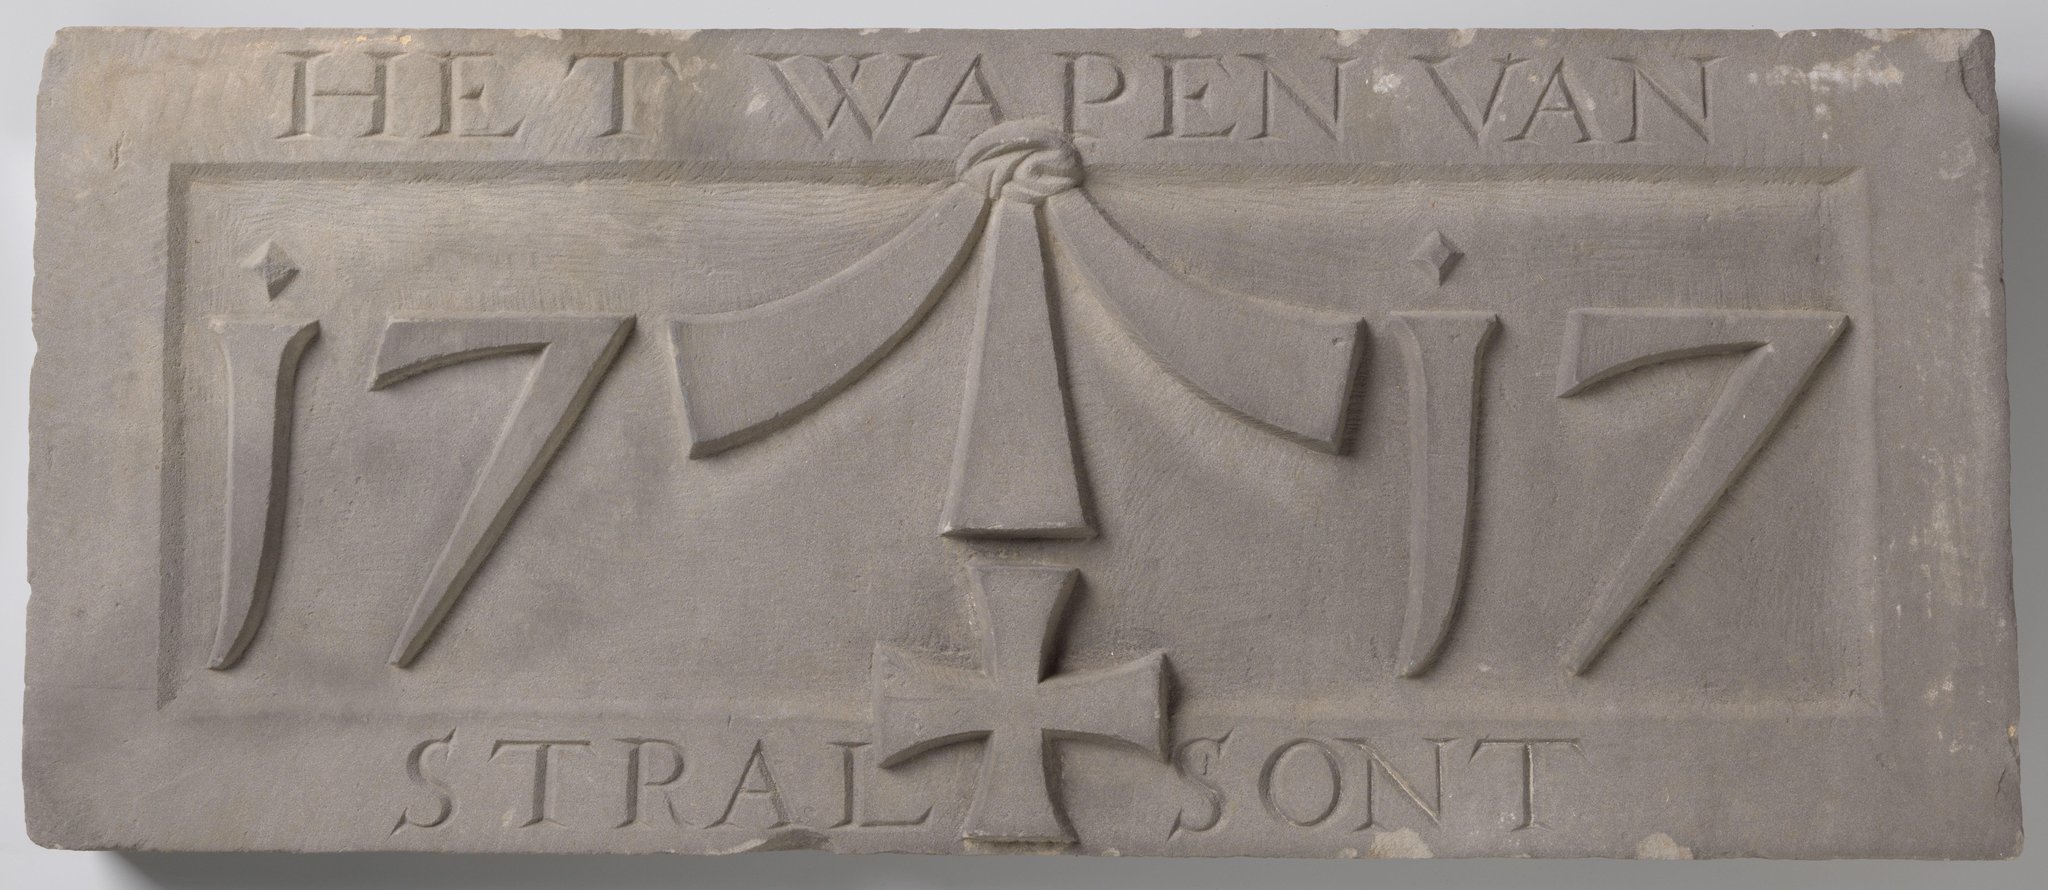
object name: gable stone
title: Gevelsteen met afbeelding en opschrift: HET WAPEN VAN STRAL SONT en getal 17.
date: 1717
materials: stone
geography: netherlands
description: Liggende rechthoek met langs de bovenrand het opschrift HET WAPEN VAN en langs de onderrand het opschrift STRAL SONT. In het middenveld een kruis met aan weerszijden het getal 17.